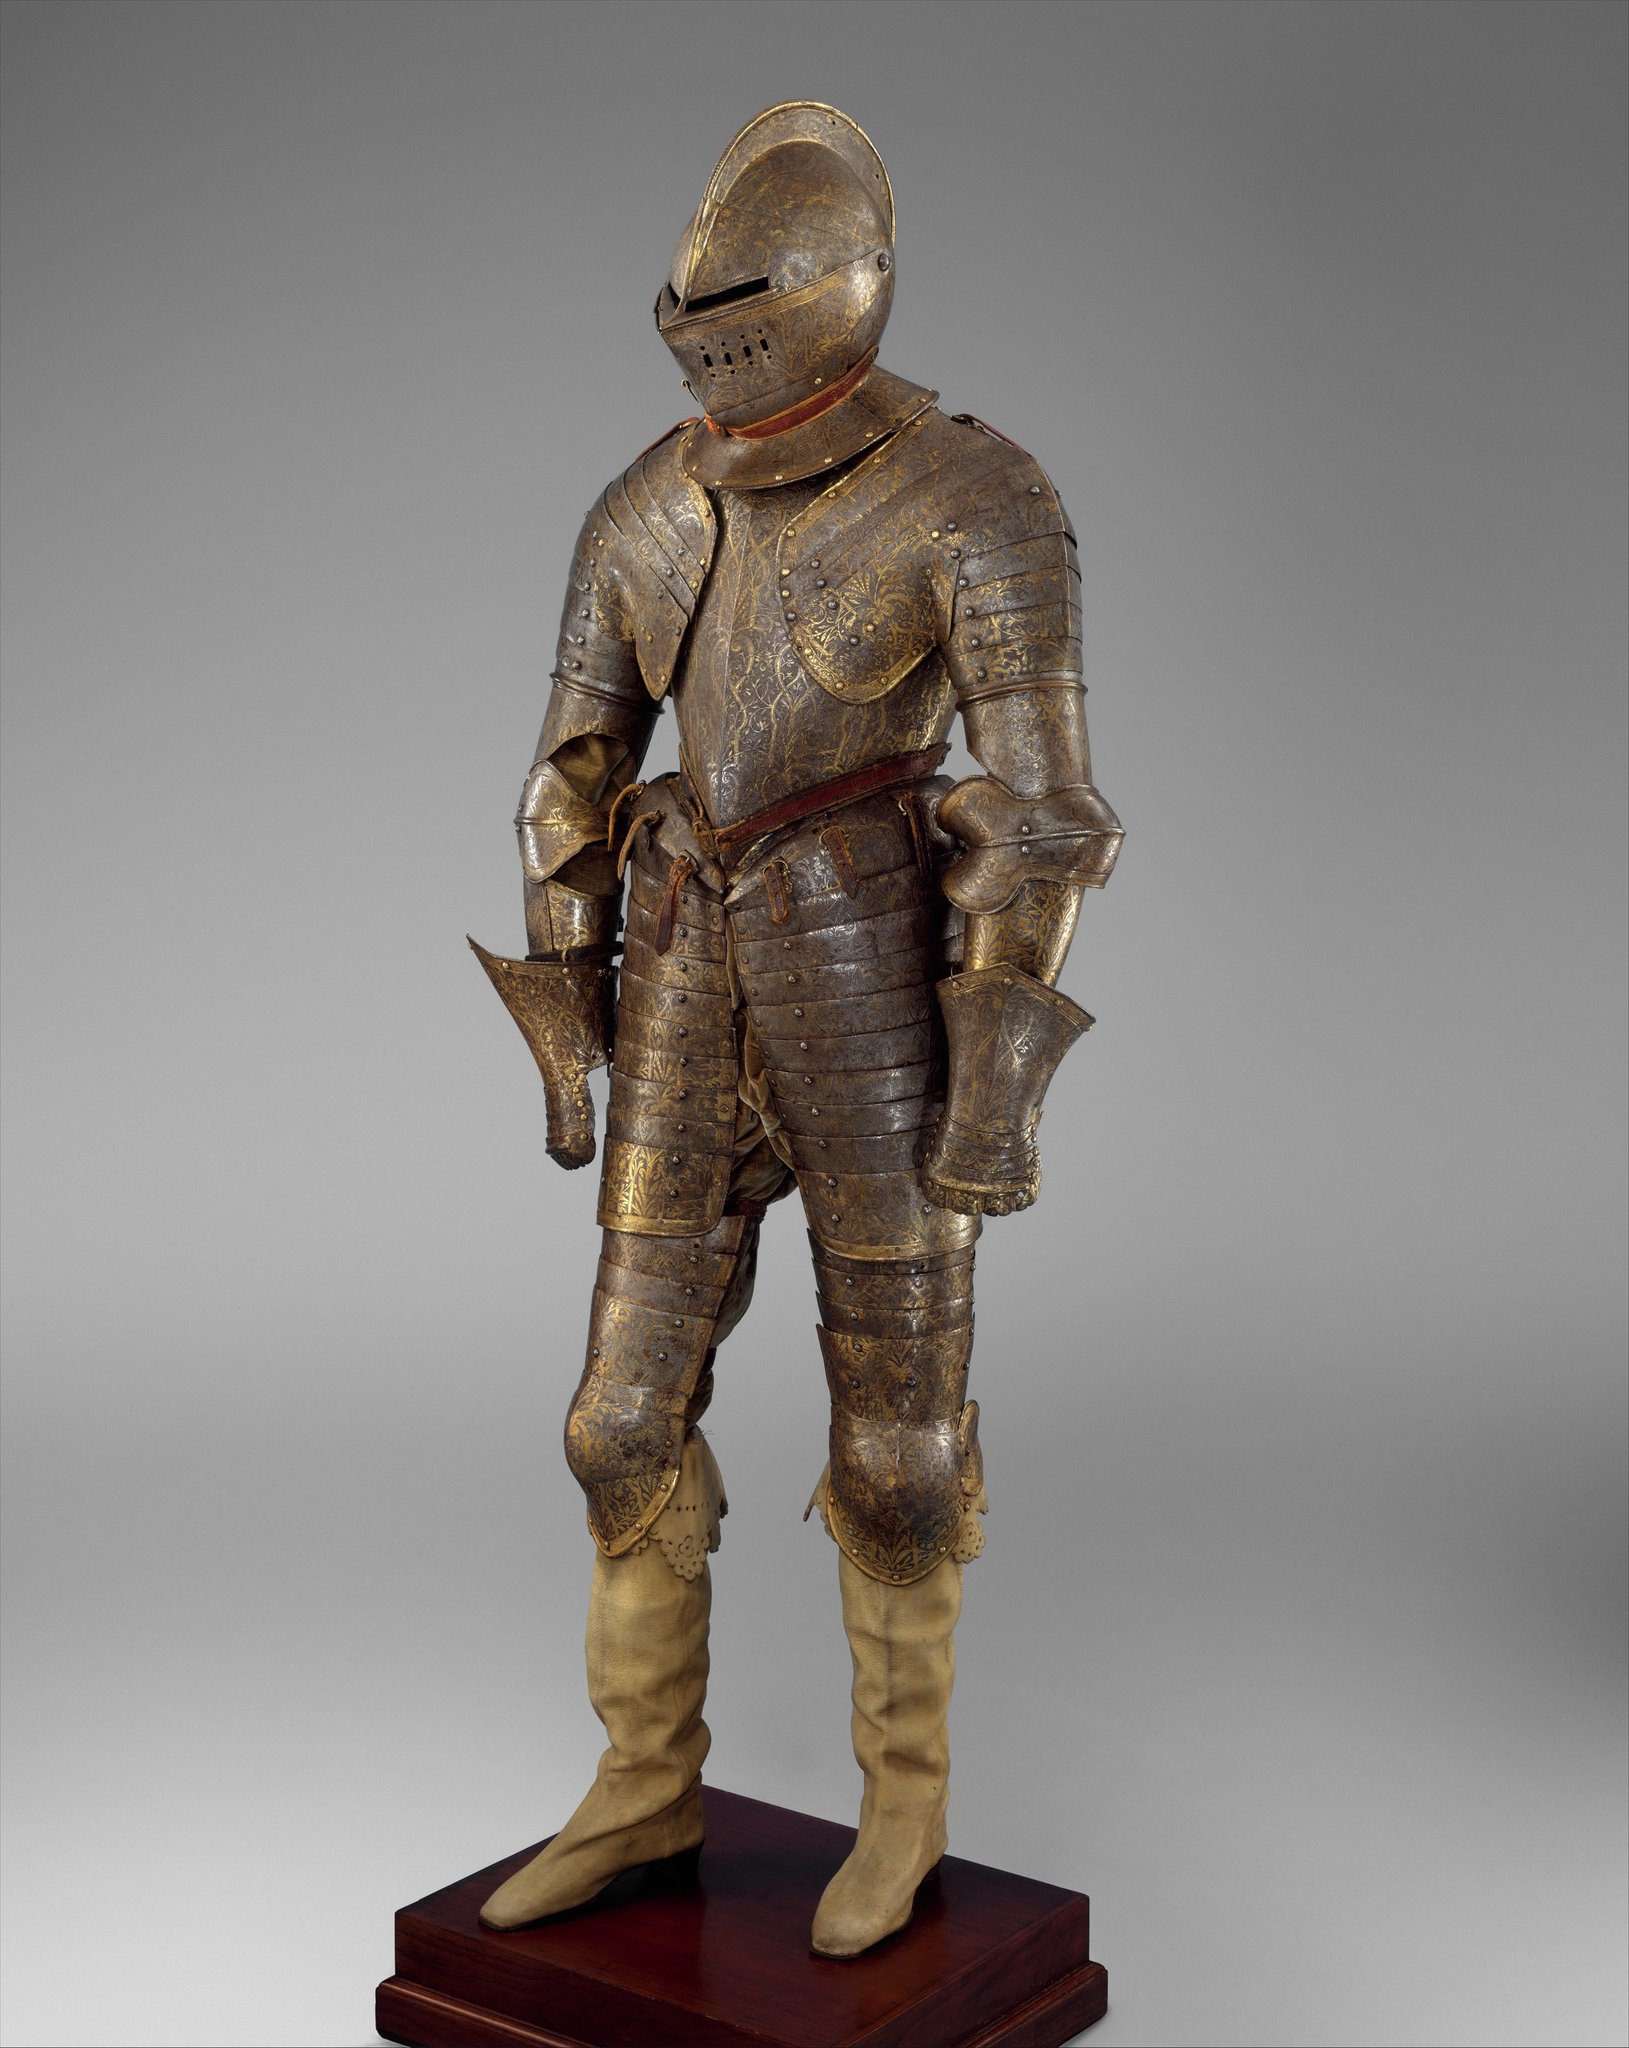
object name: armor for heavy cavalry with matching shaffron horse's head defense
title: Armor for Heavy Cavalry with Matching Shaffron (Horse's Head Defense)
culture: french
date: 1600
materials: gold, leather, steel, textile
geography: france